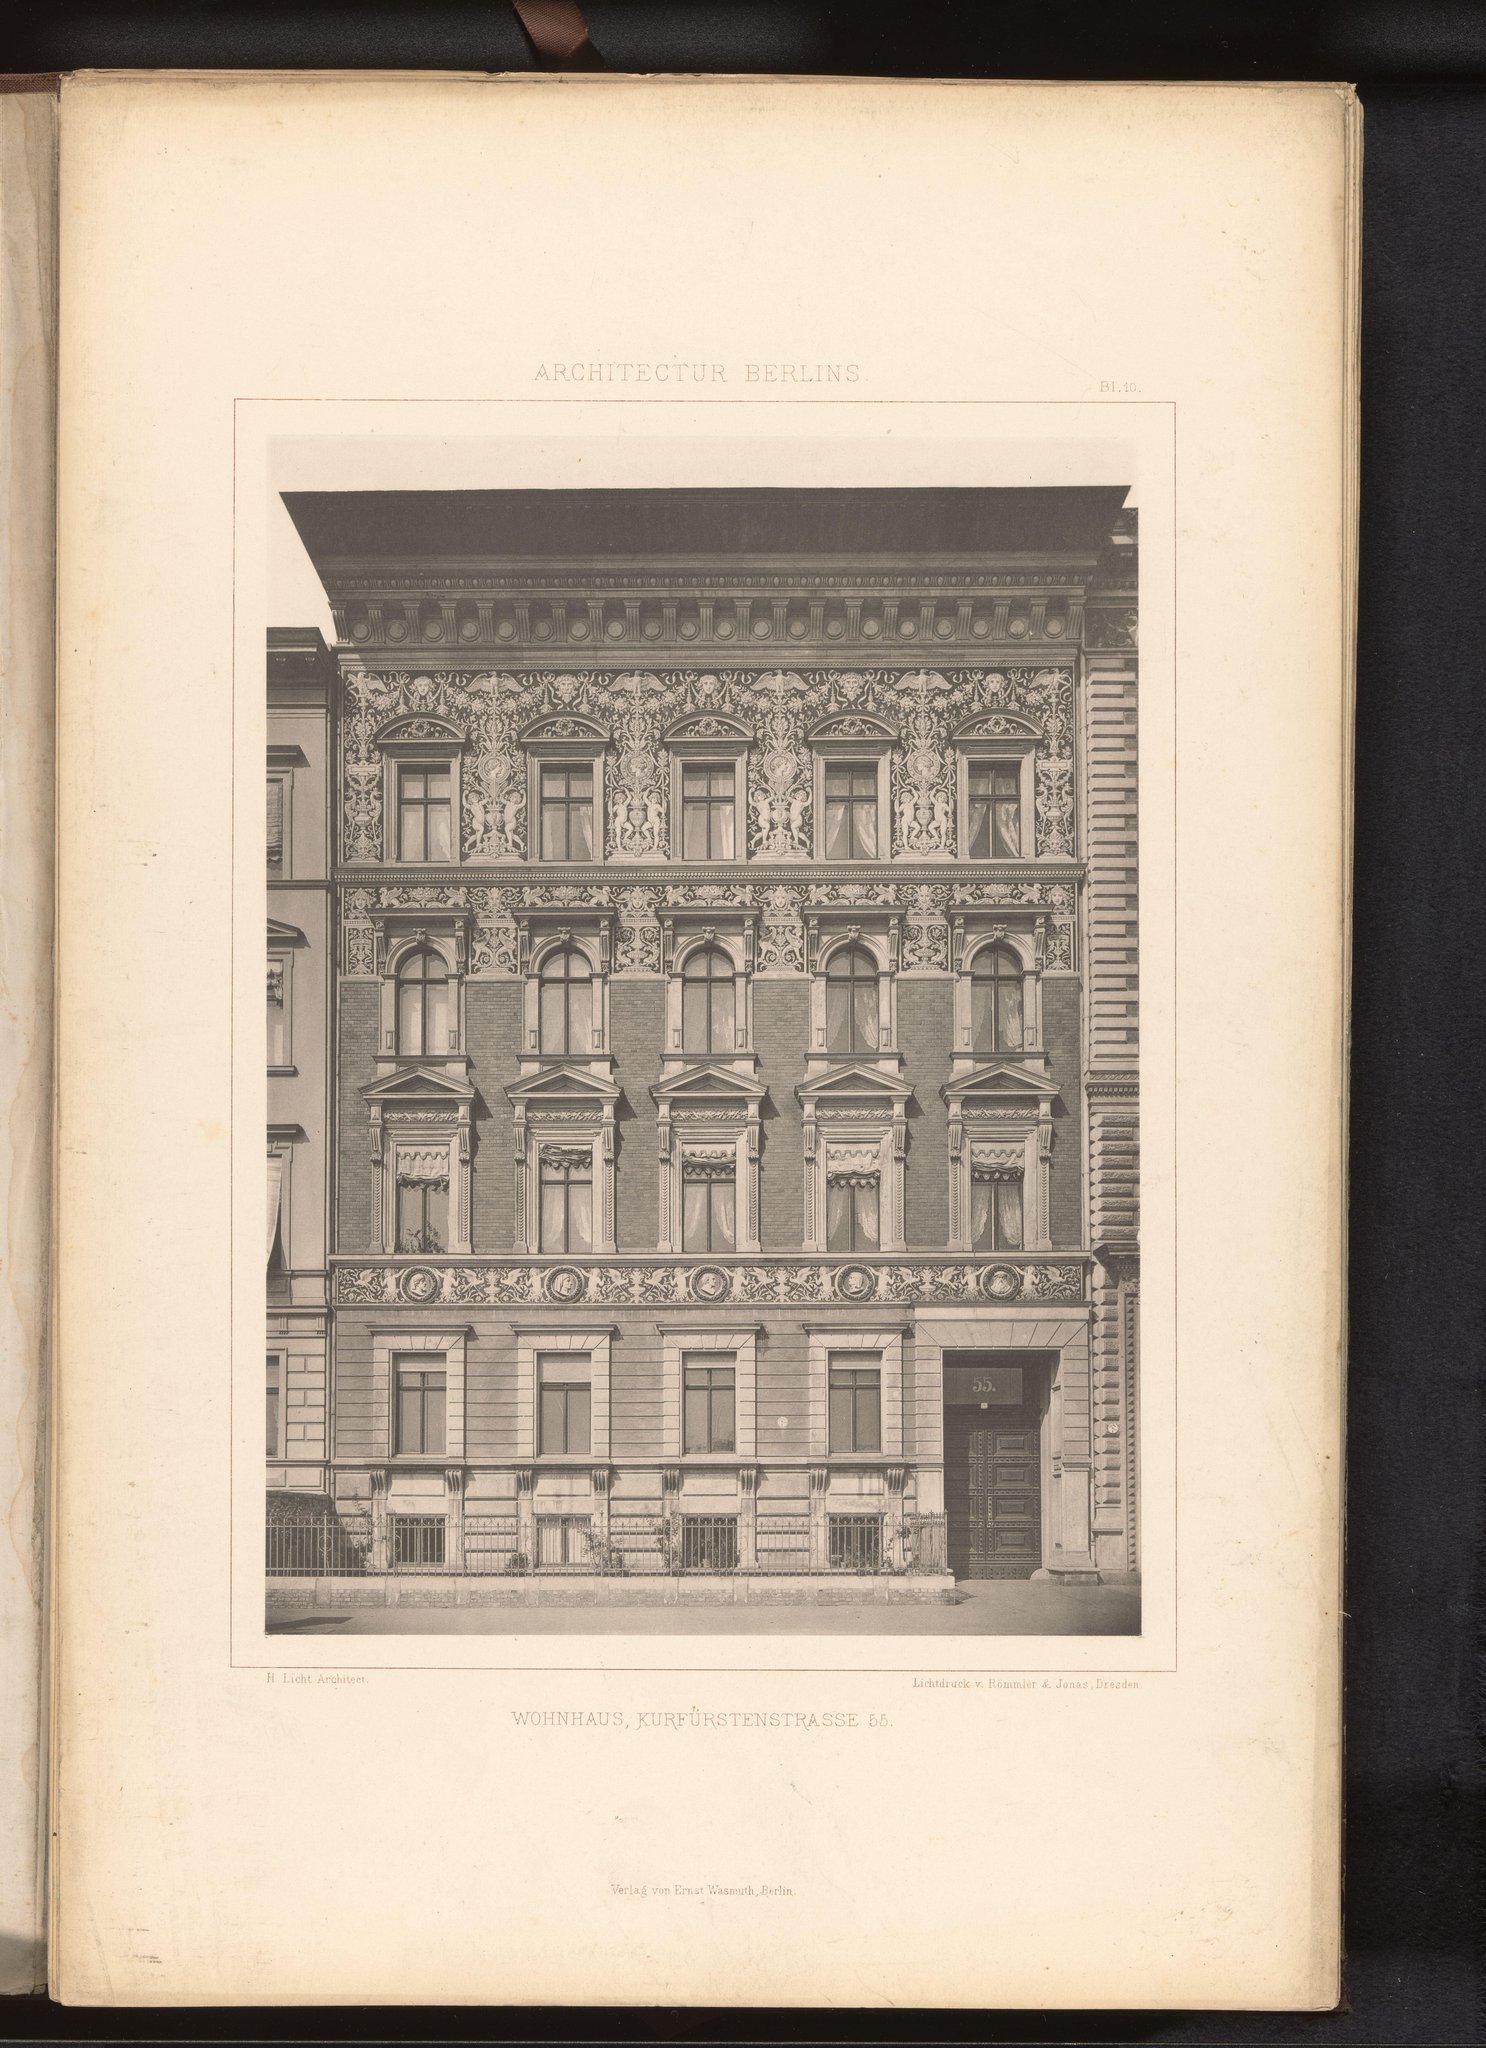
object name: photomechanical print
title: Wohnhaus, Kurfürstenstrasse 55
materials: paper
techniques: photograph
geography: dresden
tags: urban housing, berlin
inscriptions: inscription: ‘H. Licht, Architect.’, number: ‘Bl. 10.’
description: Deze prent maakt deel uit van een omslag met honderd prenten en zes tekstbladen.